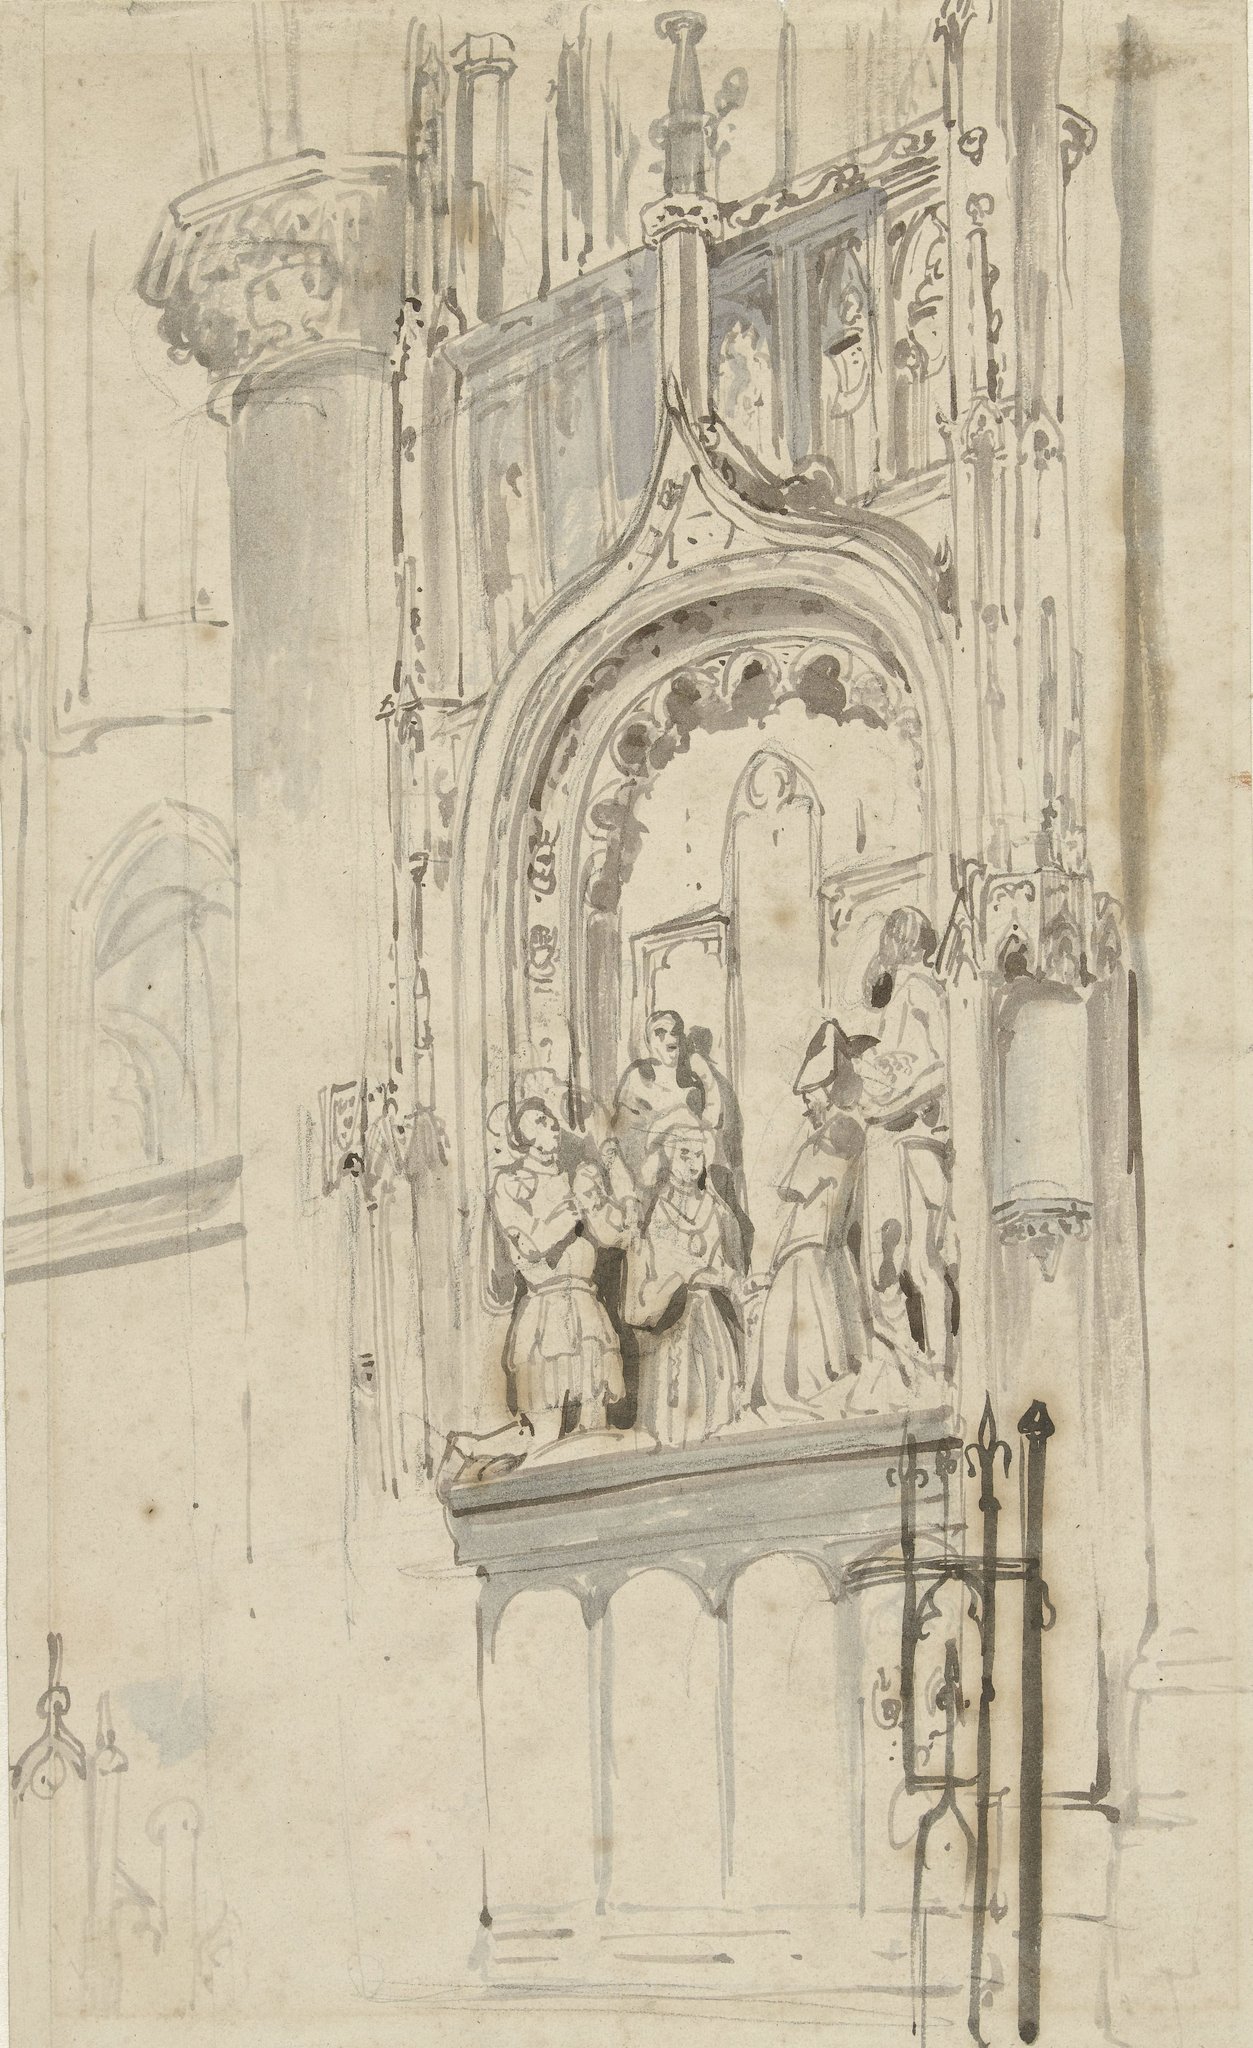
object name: drawing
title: Grafmonument van Engelbrecht I van Nassau, in de Grote Kerk te Breda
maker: johannes bosboom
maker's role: draughtsman, painter, print maker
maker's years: 1817-1891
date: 1827-1891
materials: chalk, ink, paper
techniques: brush, pen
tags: historical persons, church (exterior), grave-building, monumental tomb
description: In een schilderij alhier (SK-A-1011) is het een grafmonument van Engelbert II.